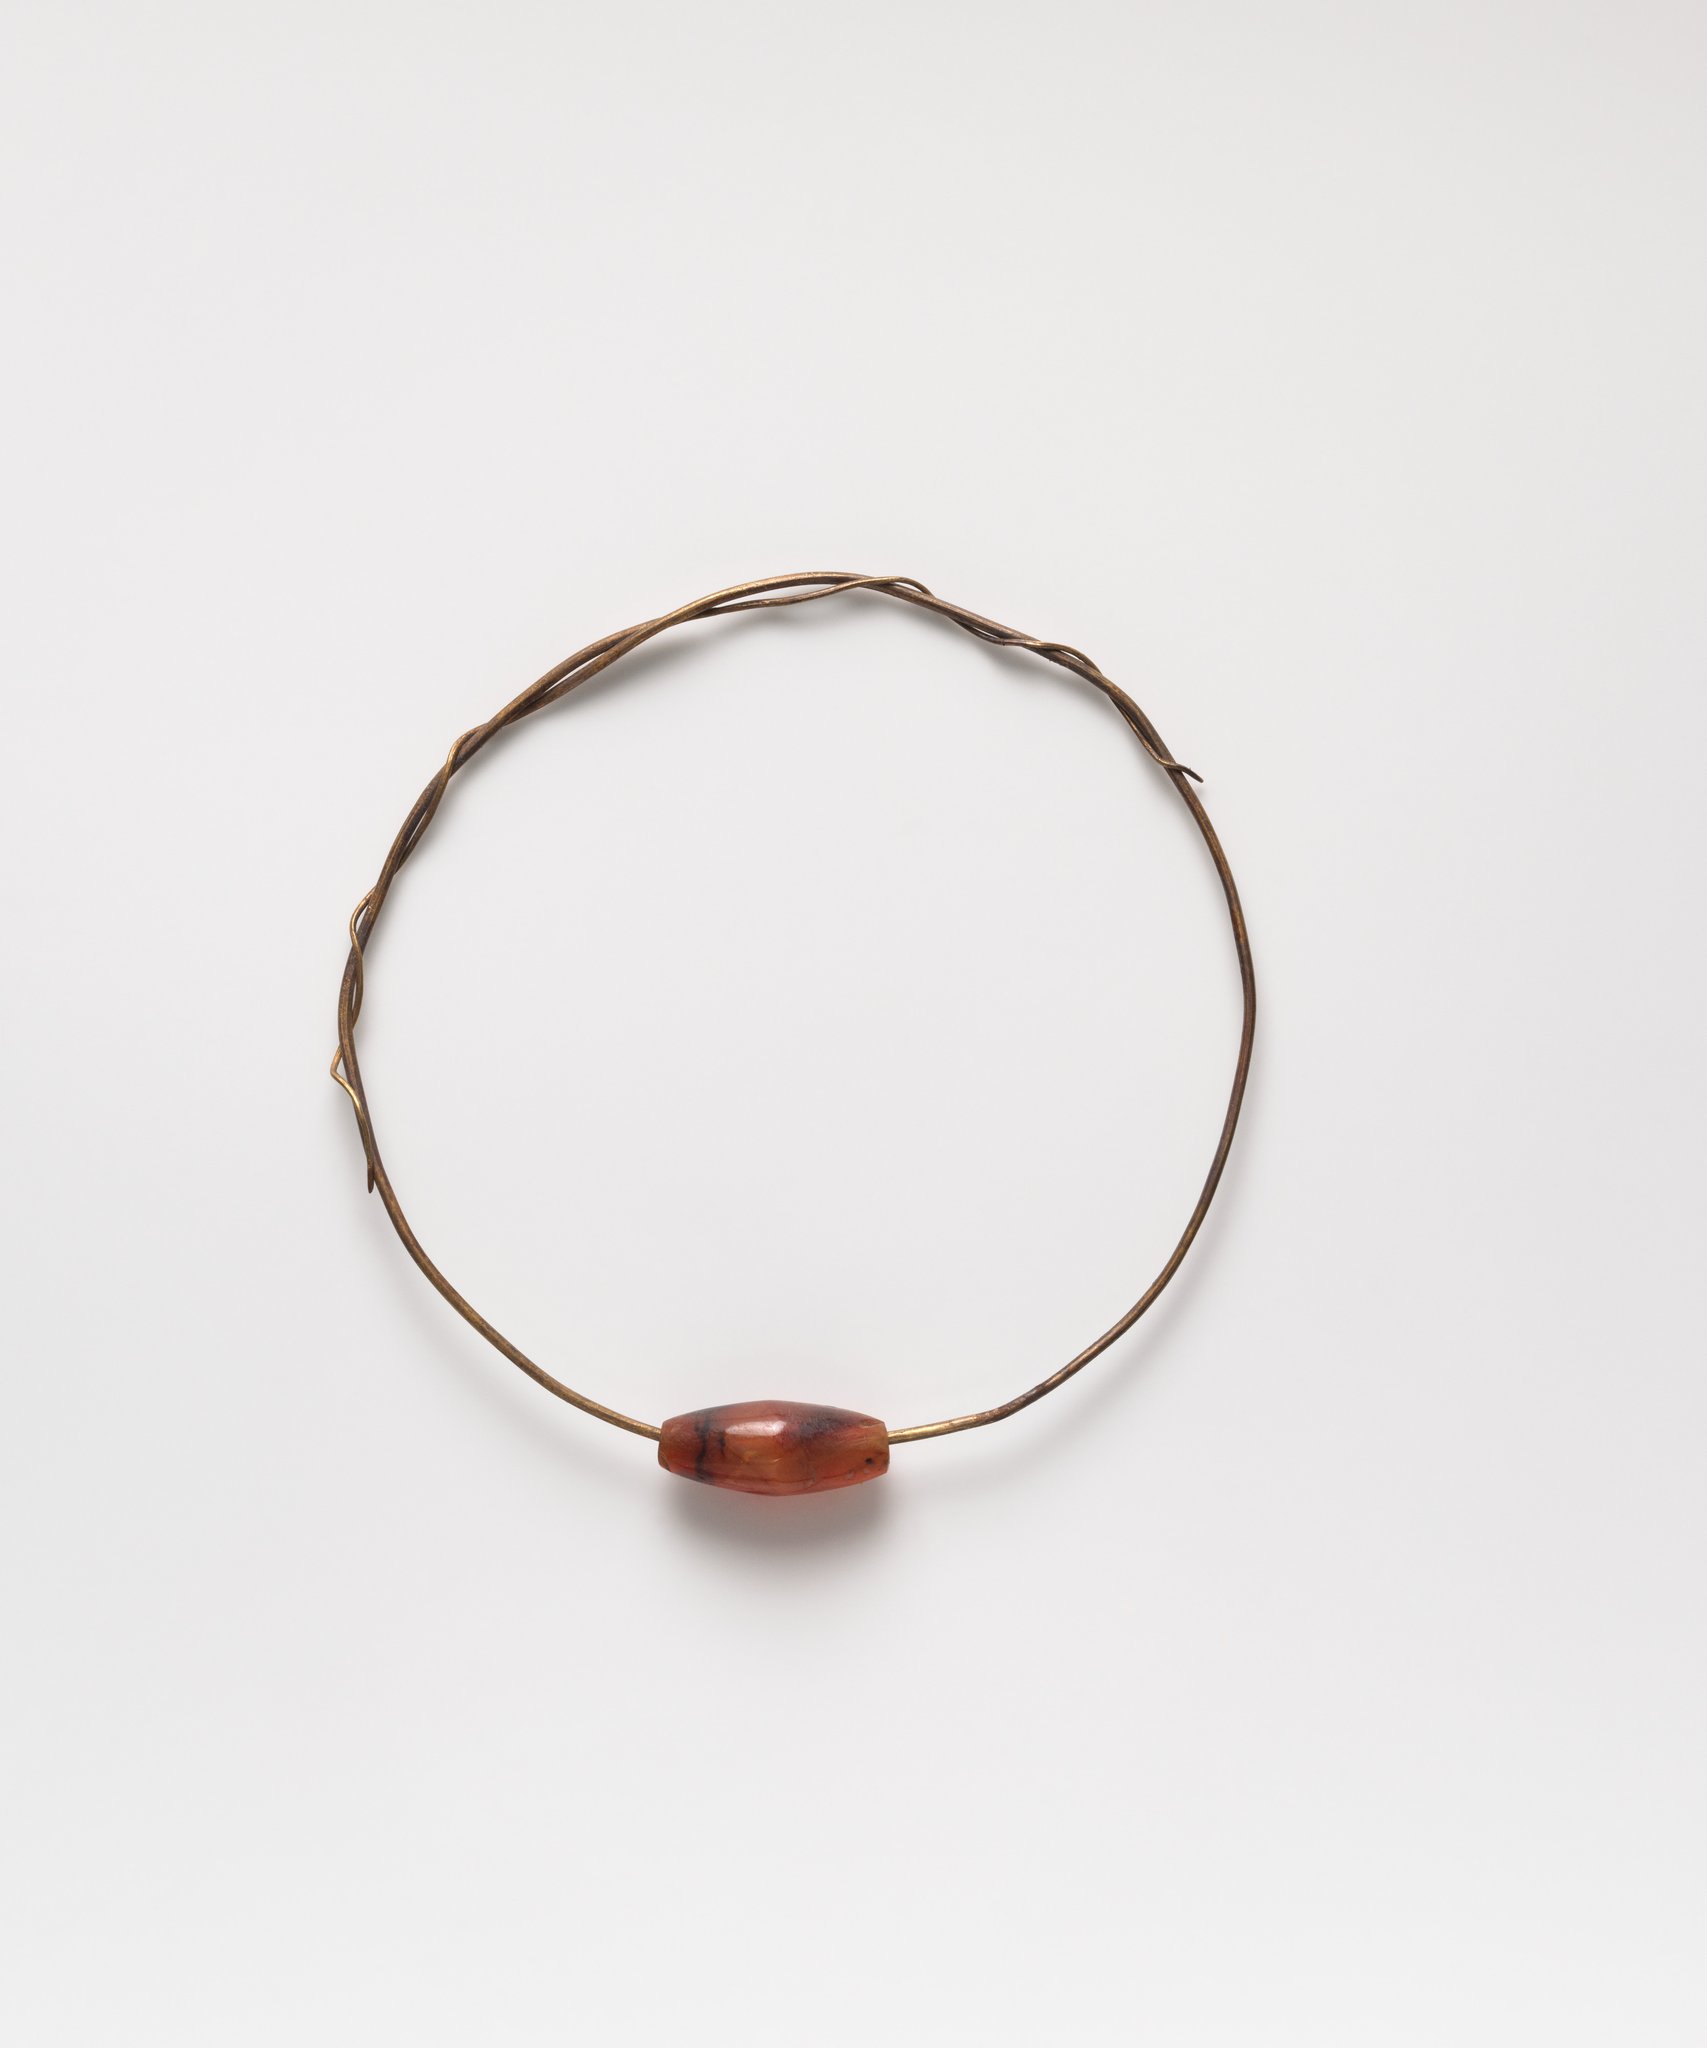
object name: necklet, sweret bead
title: Sweret Bead on Wire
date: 1479-1425 BCE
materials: gemstone, gold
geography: egypt